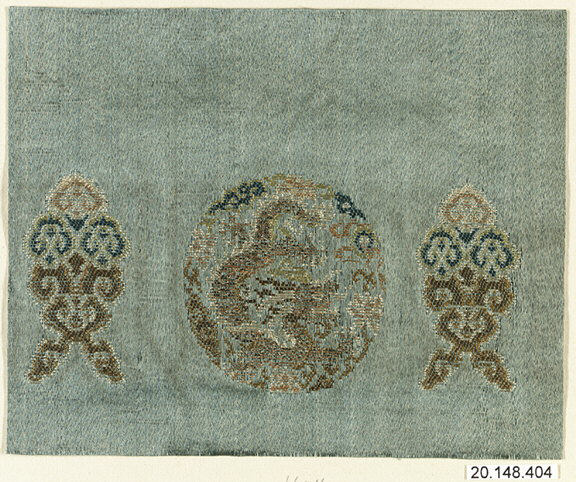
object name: piece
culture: chinese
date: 1701-1800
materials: silk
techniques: compound weave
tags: dragons